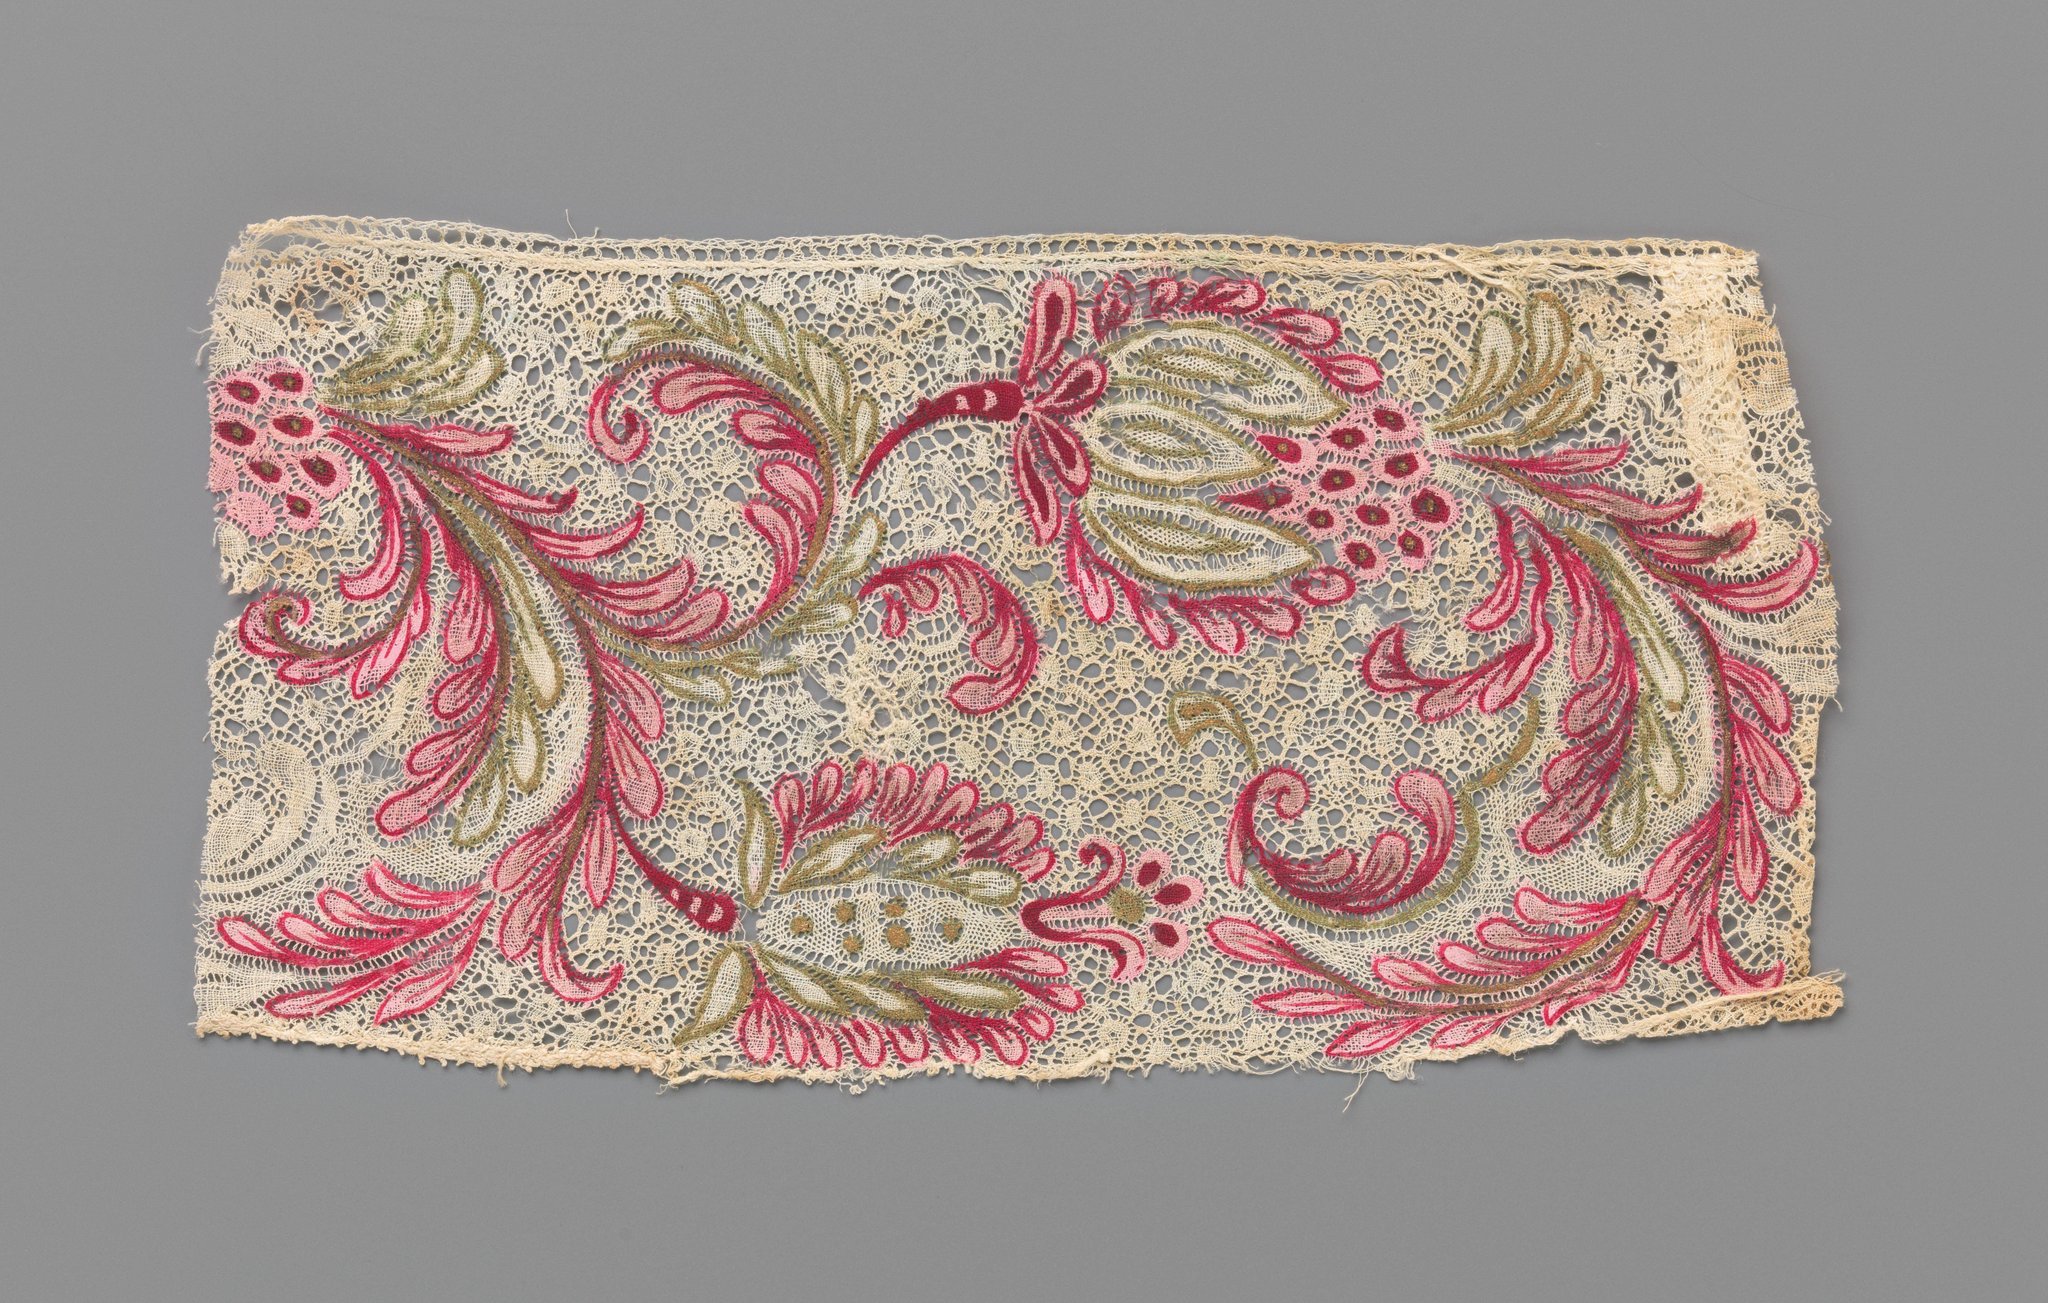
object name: strip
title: Strook kloskant met roze en goudkleurig beschilderde bloemen en bladeren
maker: Anonymous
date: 1740-1760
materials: linen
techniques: lace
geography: southern netherlands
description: Strook naturelkleurige kloskant, Binche-kant, waarbij het patroon lichtroze is beschilderd, met donkerroze en goudkleurige contourlijnen en goudkleurige stippen. Het patroon bestaat uit gevederde bladeren, gebogen en omkrullend, met een pluimvormige bloem en een bloem in de vorm van een dennenappel. De motieven zijn met elkaar verbonden door een siergrond, een sneeuwvlokkengrond. Het volwerk is grotendeels gemaakt in linnenslag met opengewerkte randjes. Tussen sommige bladeren en in de bloemen is een netslagvulling toegepast. De onderzijde van de strook is recht afgewerkt. De bovenzijde is afgewerkt met een apart geklost bandje.